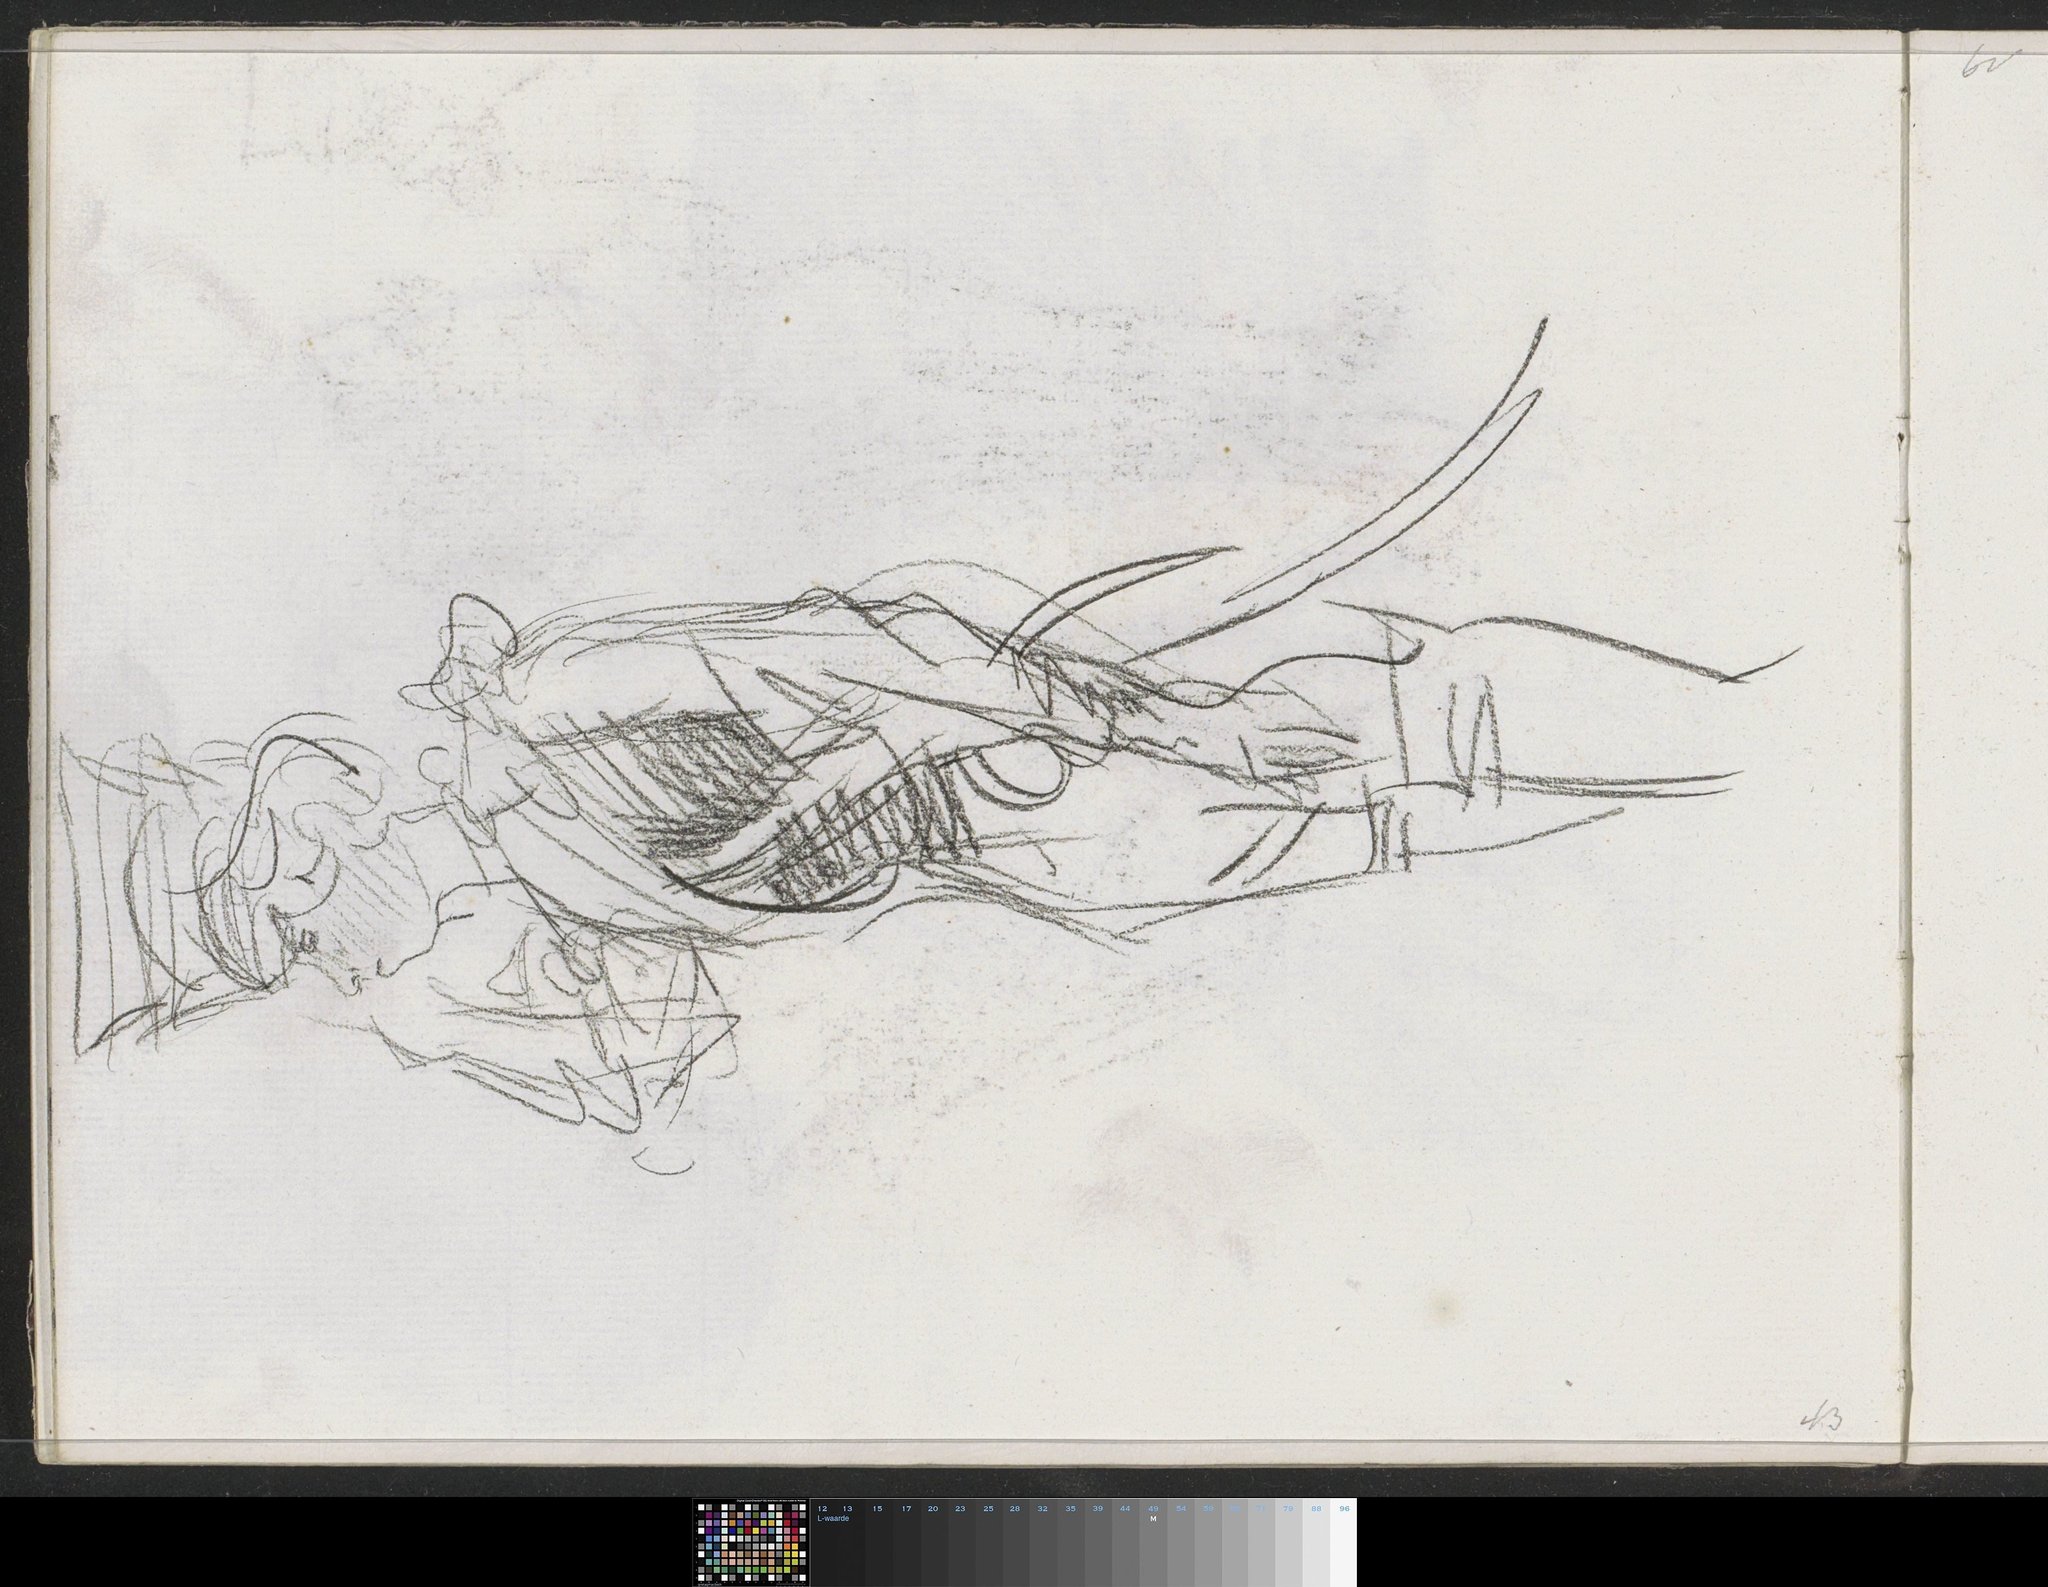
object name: sketchbook leaf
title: Staande vrouw in uniform met sabel, in profiel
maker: isaac israels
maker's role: draughtsman, painter, print maker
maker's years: 1865-1934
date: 1875-1934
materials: chalk, paper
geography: the hague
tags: sabre (~ fencing), adult woman (+ standing), (military) uniforms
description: Blad 12 verso uit schetsboek XXII met 30 bladen.